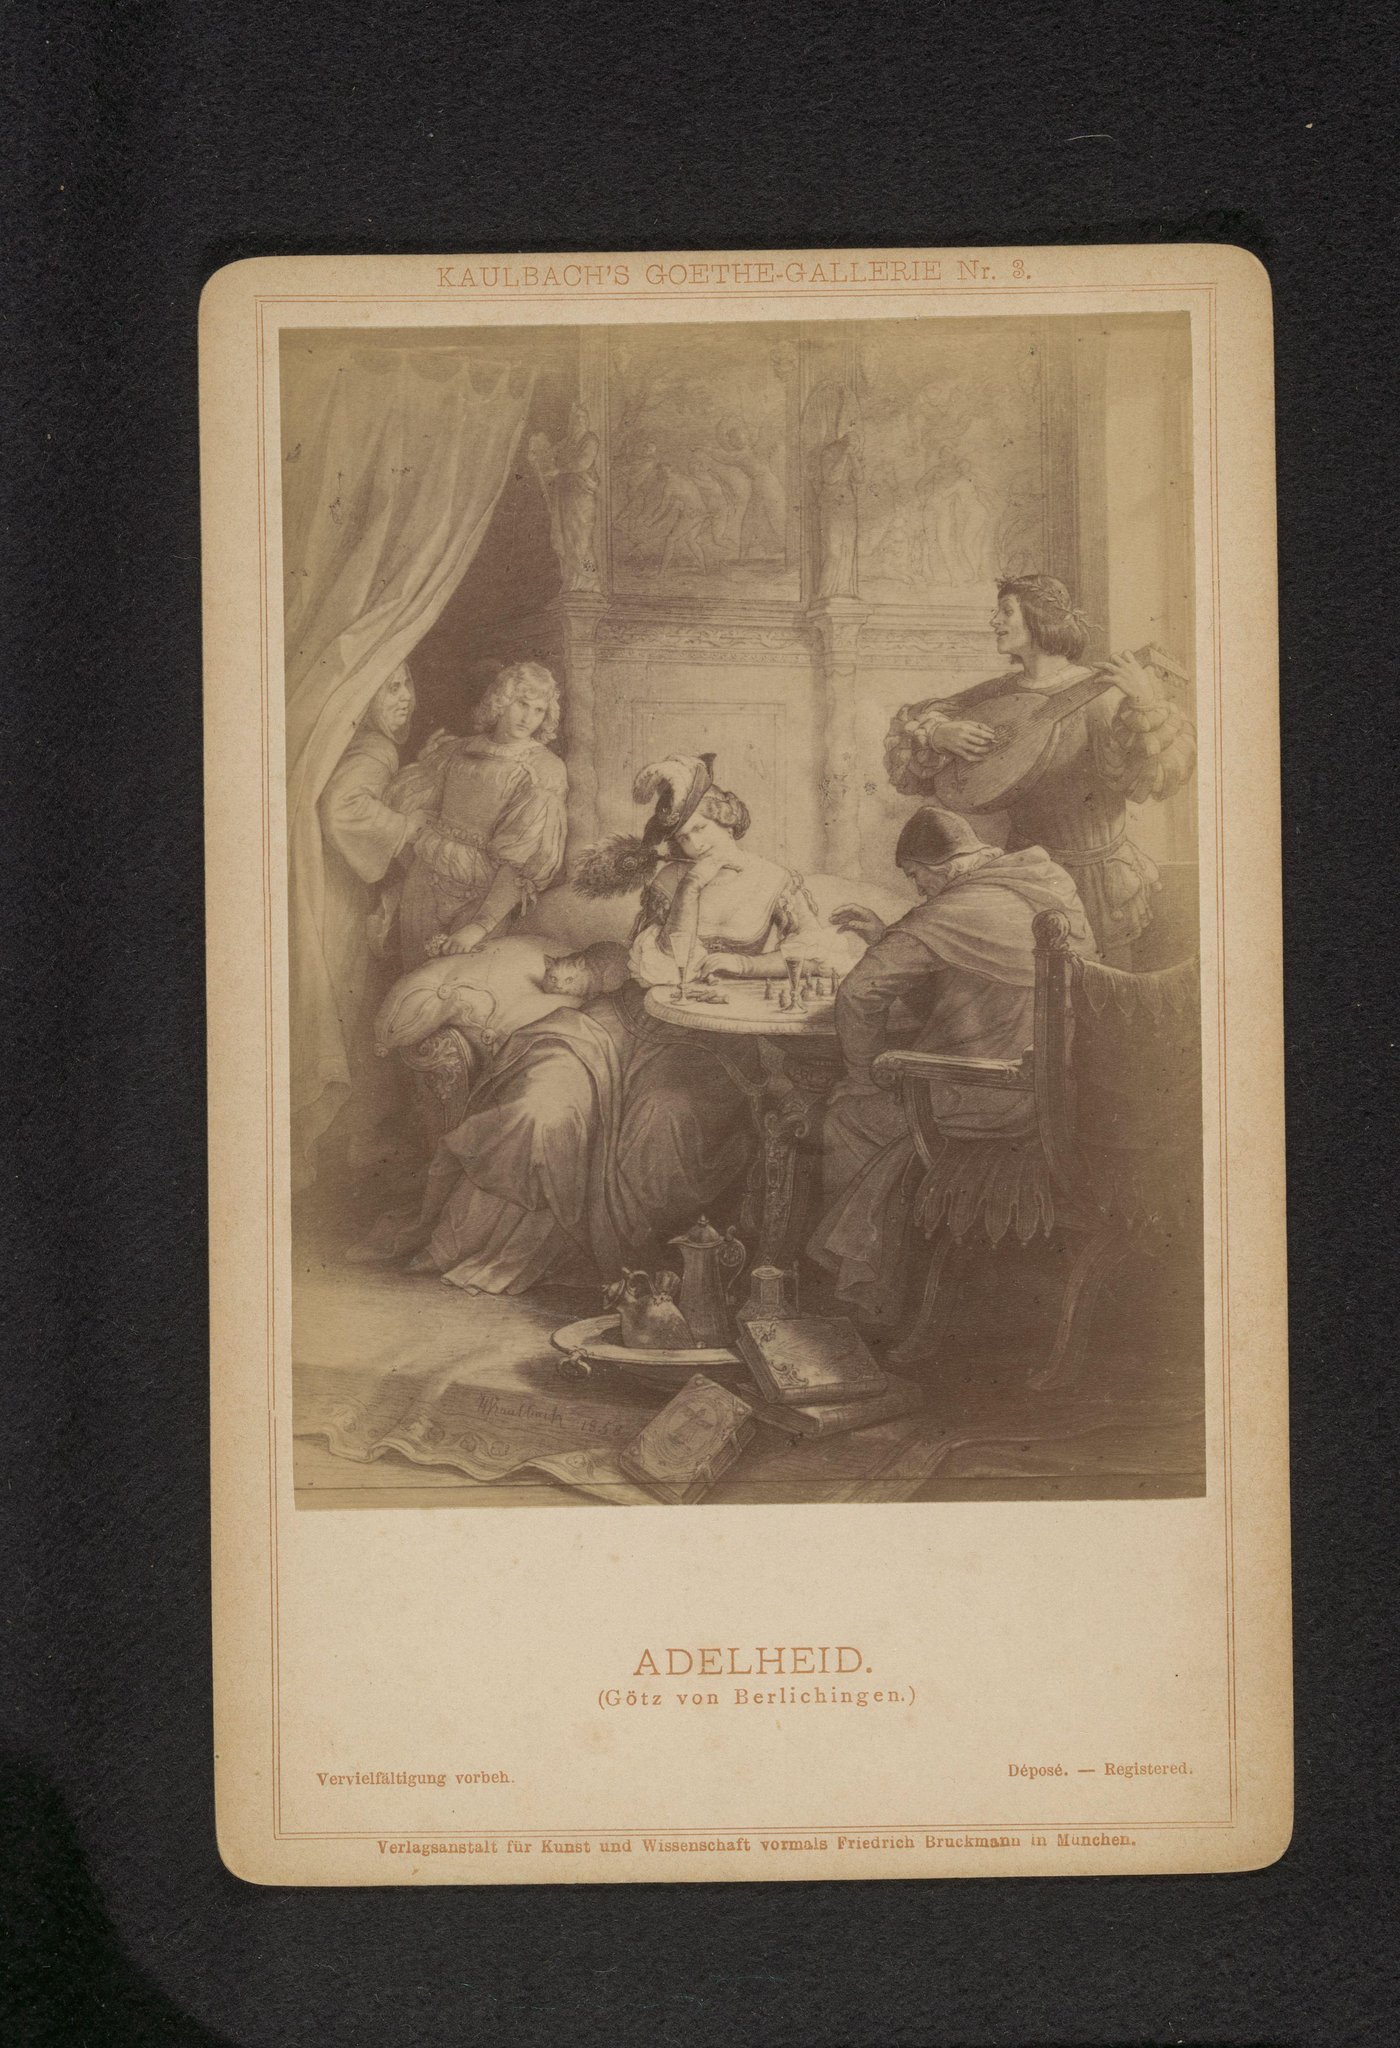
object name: photograph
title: Fotoreproductie van een scène met Adelheid uit Goethe's Götz von Berlichingen met de ijzeren hand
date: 1880-1885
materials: photographic support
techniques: albumen print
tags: chess, literary characters and objects, lute, and special forms of lute, e.g.: theorbo, painting, drawing and the graphic arts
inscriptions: inscription: ‘Kaulbach's Goethe-Gallerie Nr. 3’, inscription: ‘Vervielfältigung vorbeh. Déposé - Registered./ Verlagsanstalt für Kunst und Wissenschaft vormals Friedrich Bruckmann in München.’, name: ‘Friedrich Bruckmann's Verlag/ München’, annotation: ‘24.12.94’